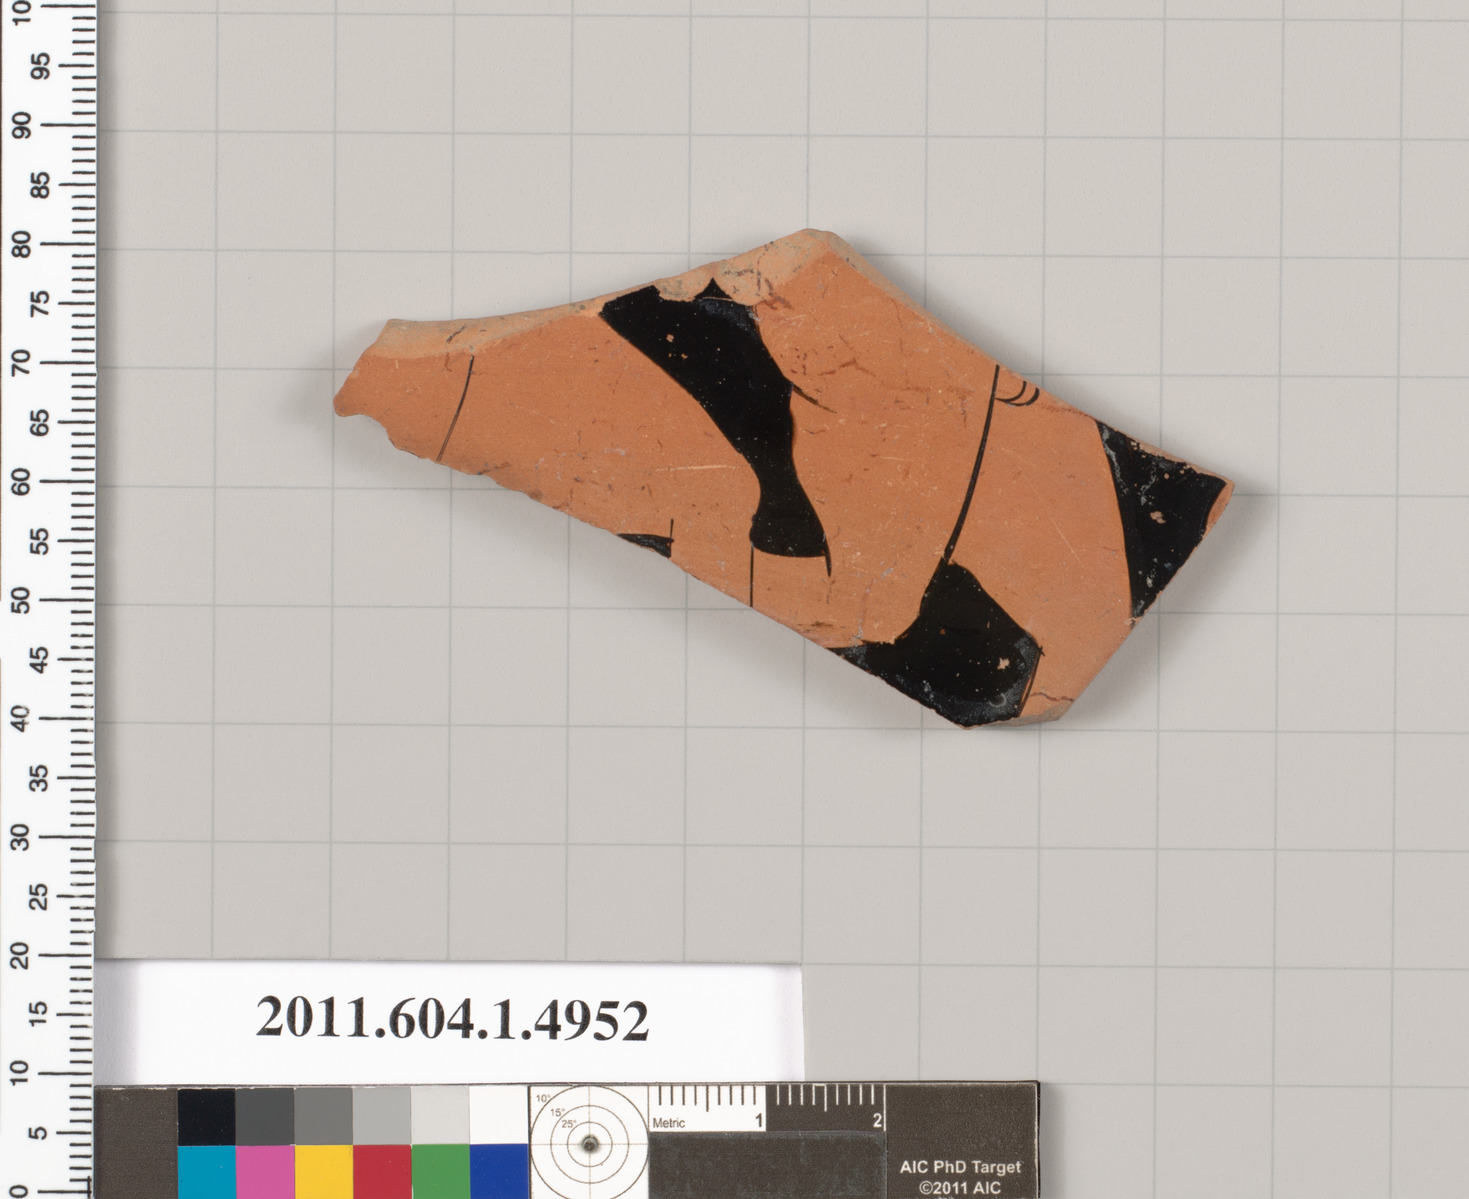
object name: kylix fragment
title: Terracotta fragment of a kylix (drinking cup)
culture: greek, attic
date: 510-480 BCE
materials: terracotta